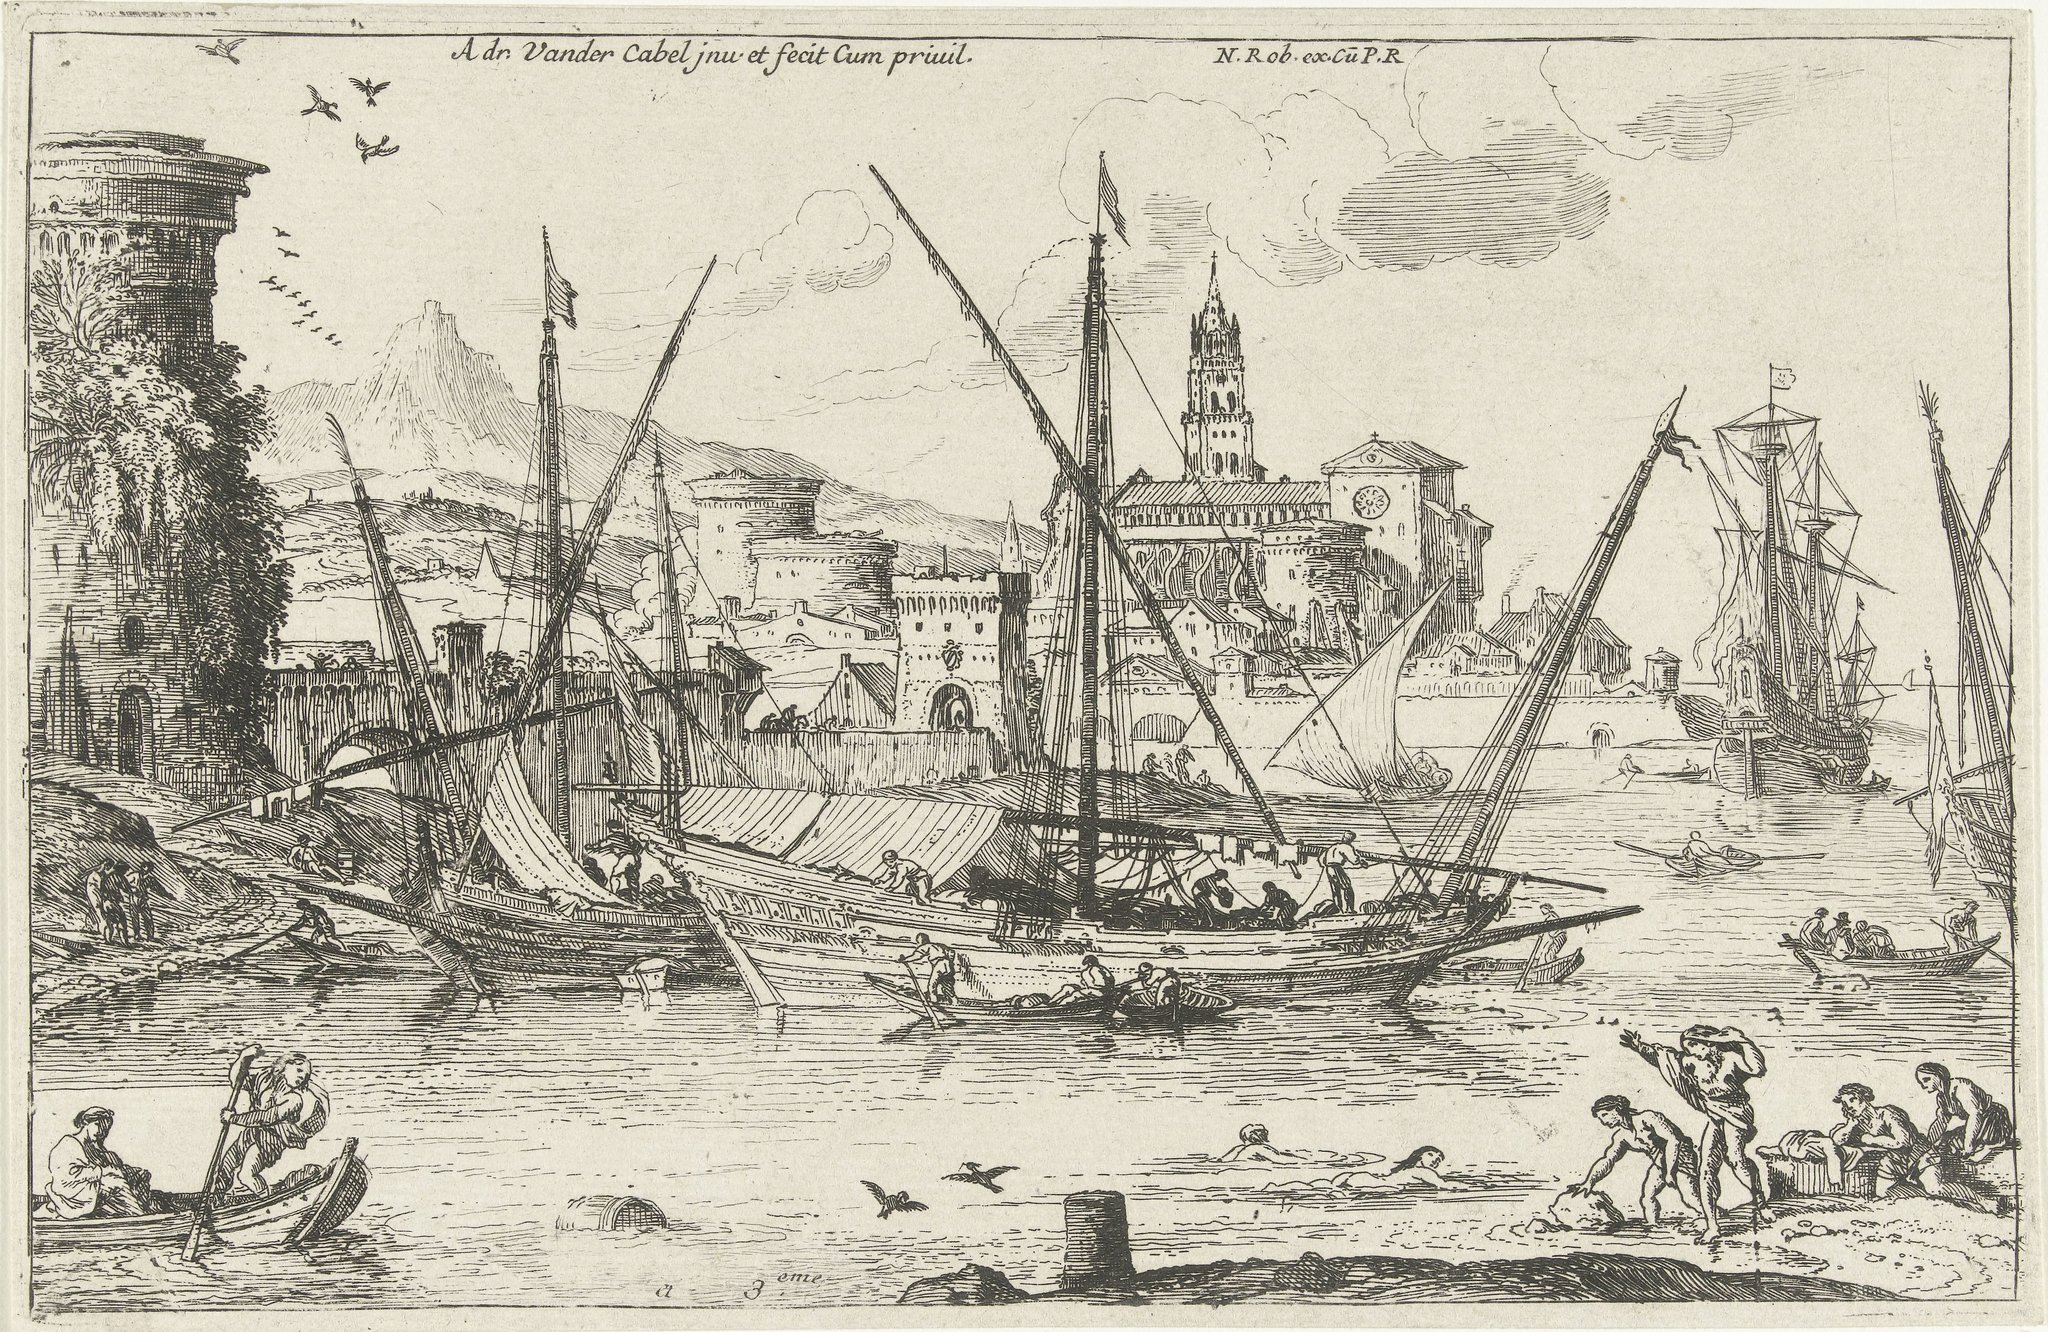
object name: print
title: Haven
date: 1648-1705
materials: paper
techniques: etching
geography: france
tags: harbour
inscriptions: collector's mark: Lugt 2926, collector's mark: Lugt 2252, collector's mark: Lugt 2228, collector's mark: Lugt 2760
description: Gezicht op een haven met zeilschepen en roeiboten. Op de voorgrond badende mensen, op de achtergrond een stad met kathedraal.